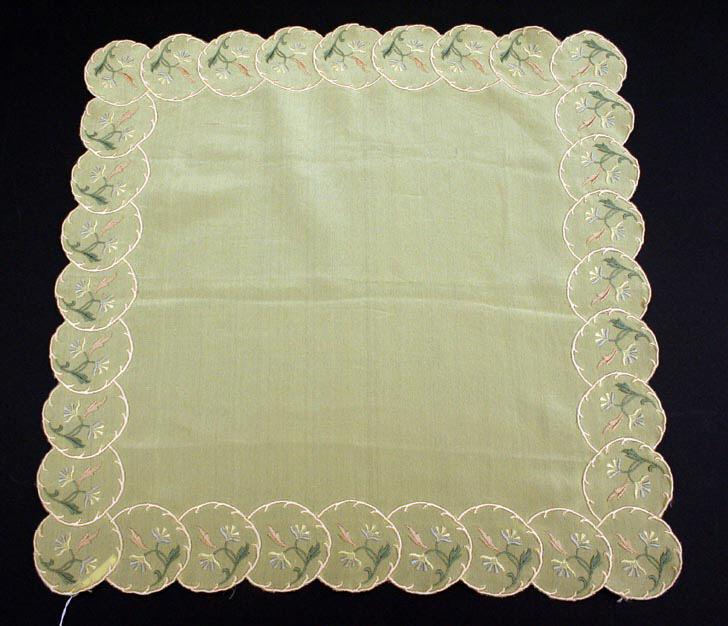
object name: handkerchief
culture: american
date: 1882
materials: silk